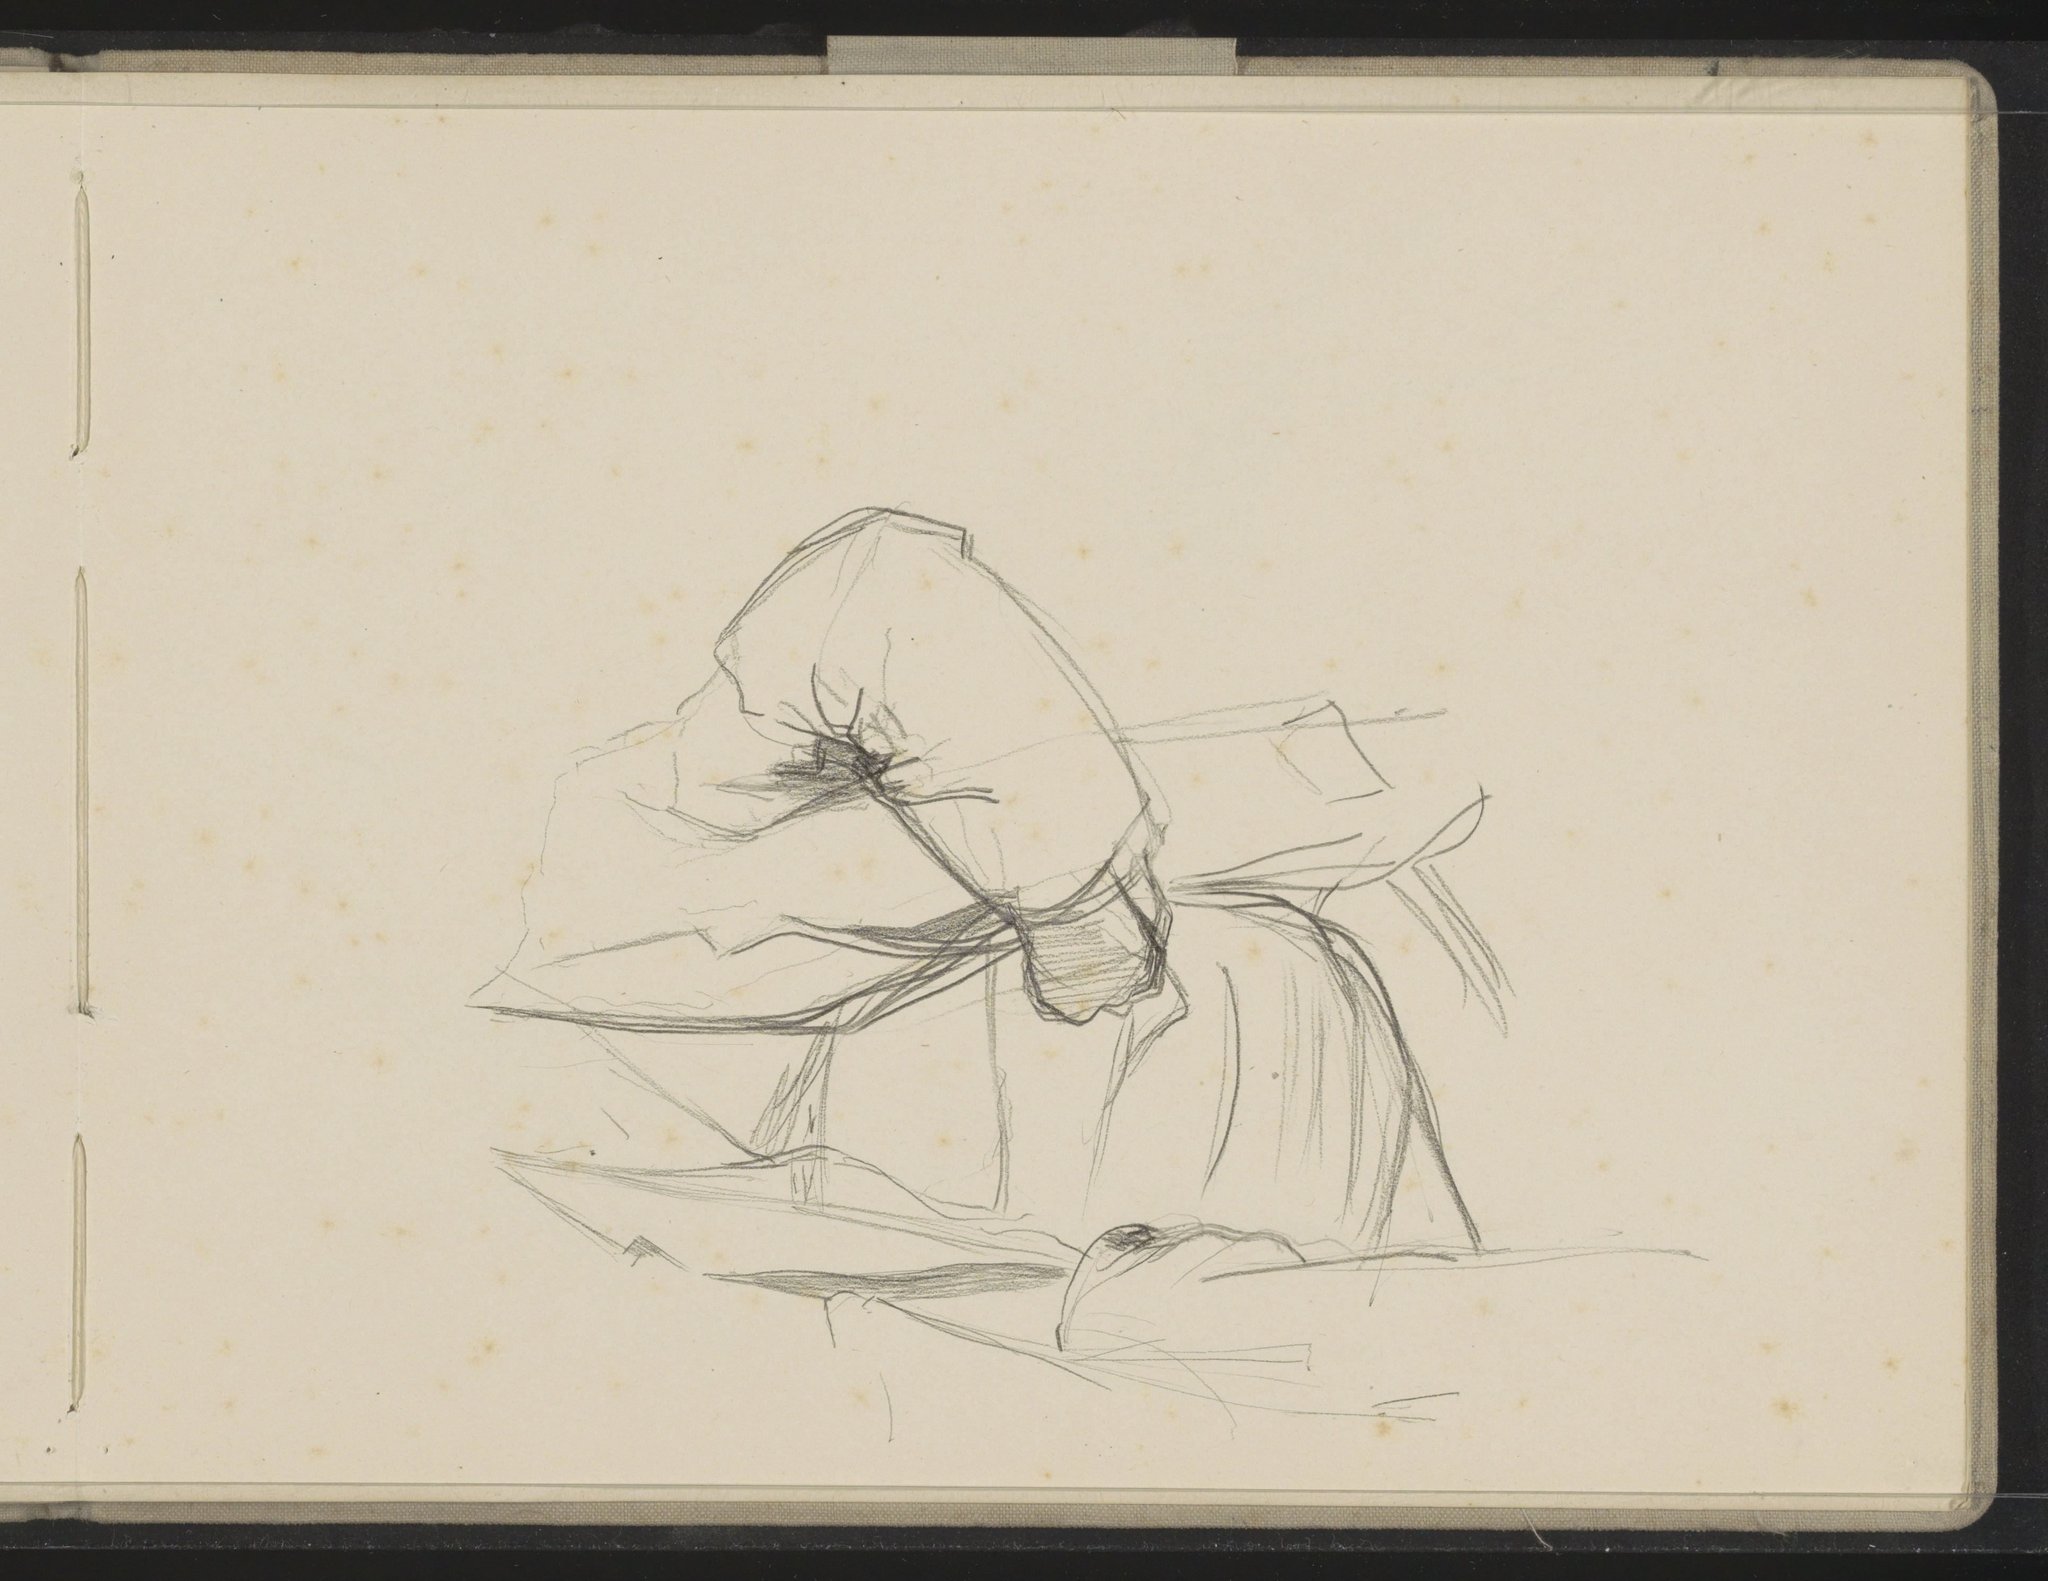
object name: sketchbook leaf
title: Zittende man met hand in de zij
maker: ferdinand oldewelt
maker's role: draughtsman, print maker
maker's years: 1857-1935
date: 1908-1923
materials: chalk, paper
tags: sitting figure, hand on the hip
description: De man draagt een colbert en zit met de benen over elkaar. Blad 32 recto uit een schetsboek met 35 bladen.